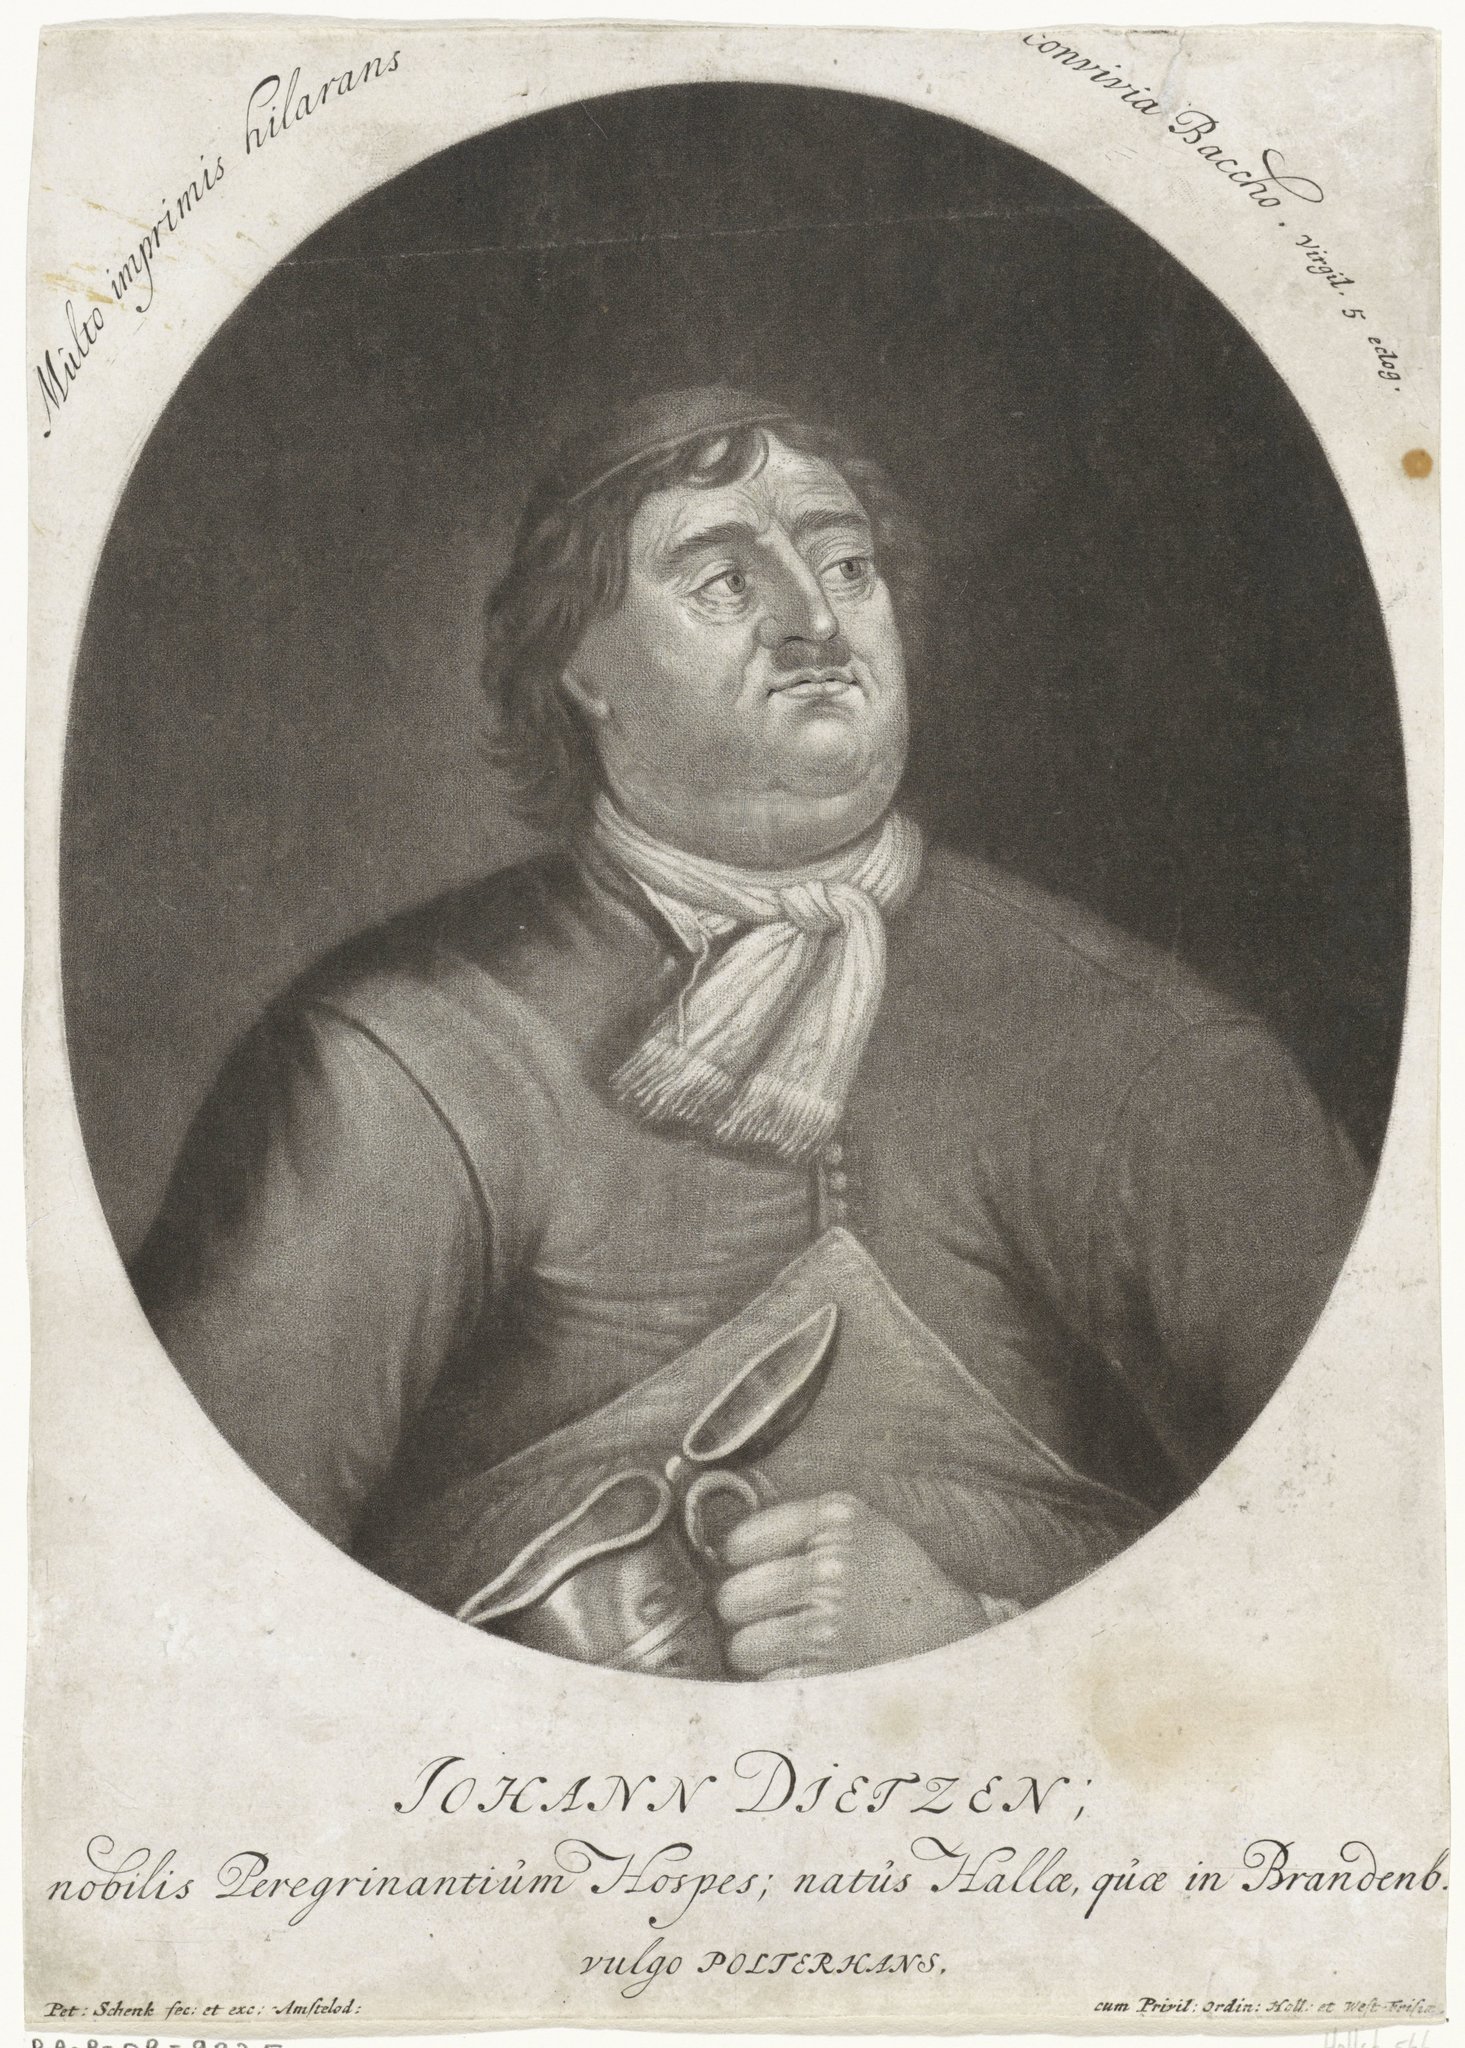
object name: print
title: Portret van Johann Dietzen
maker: pieter schenk (i)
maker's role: print maker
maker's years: 1660-1711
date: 1670-1713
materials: paper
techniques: engraving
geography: amsterdam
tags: johann dietzen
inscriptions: collector's mark: Lugt 2228